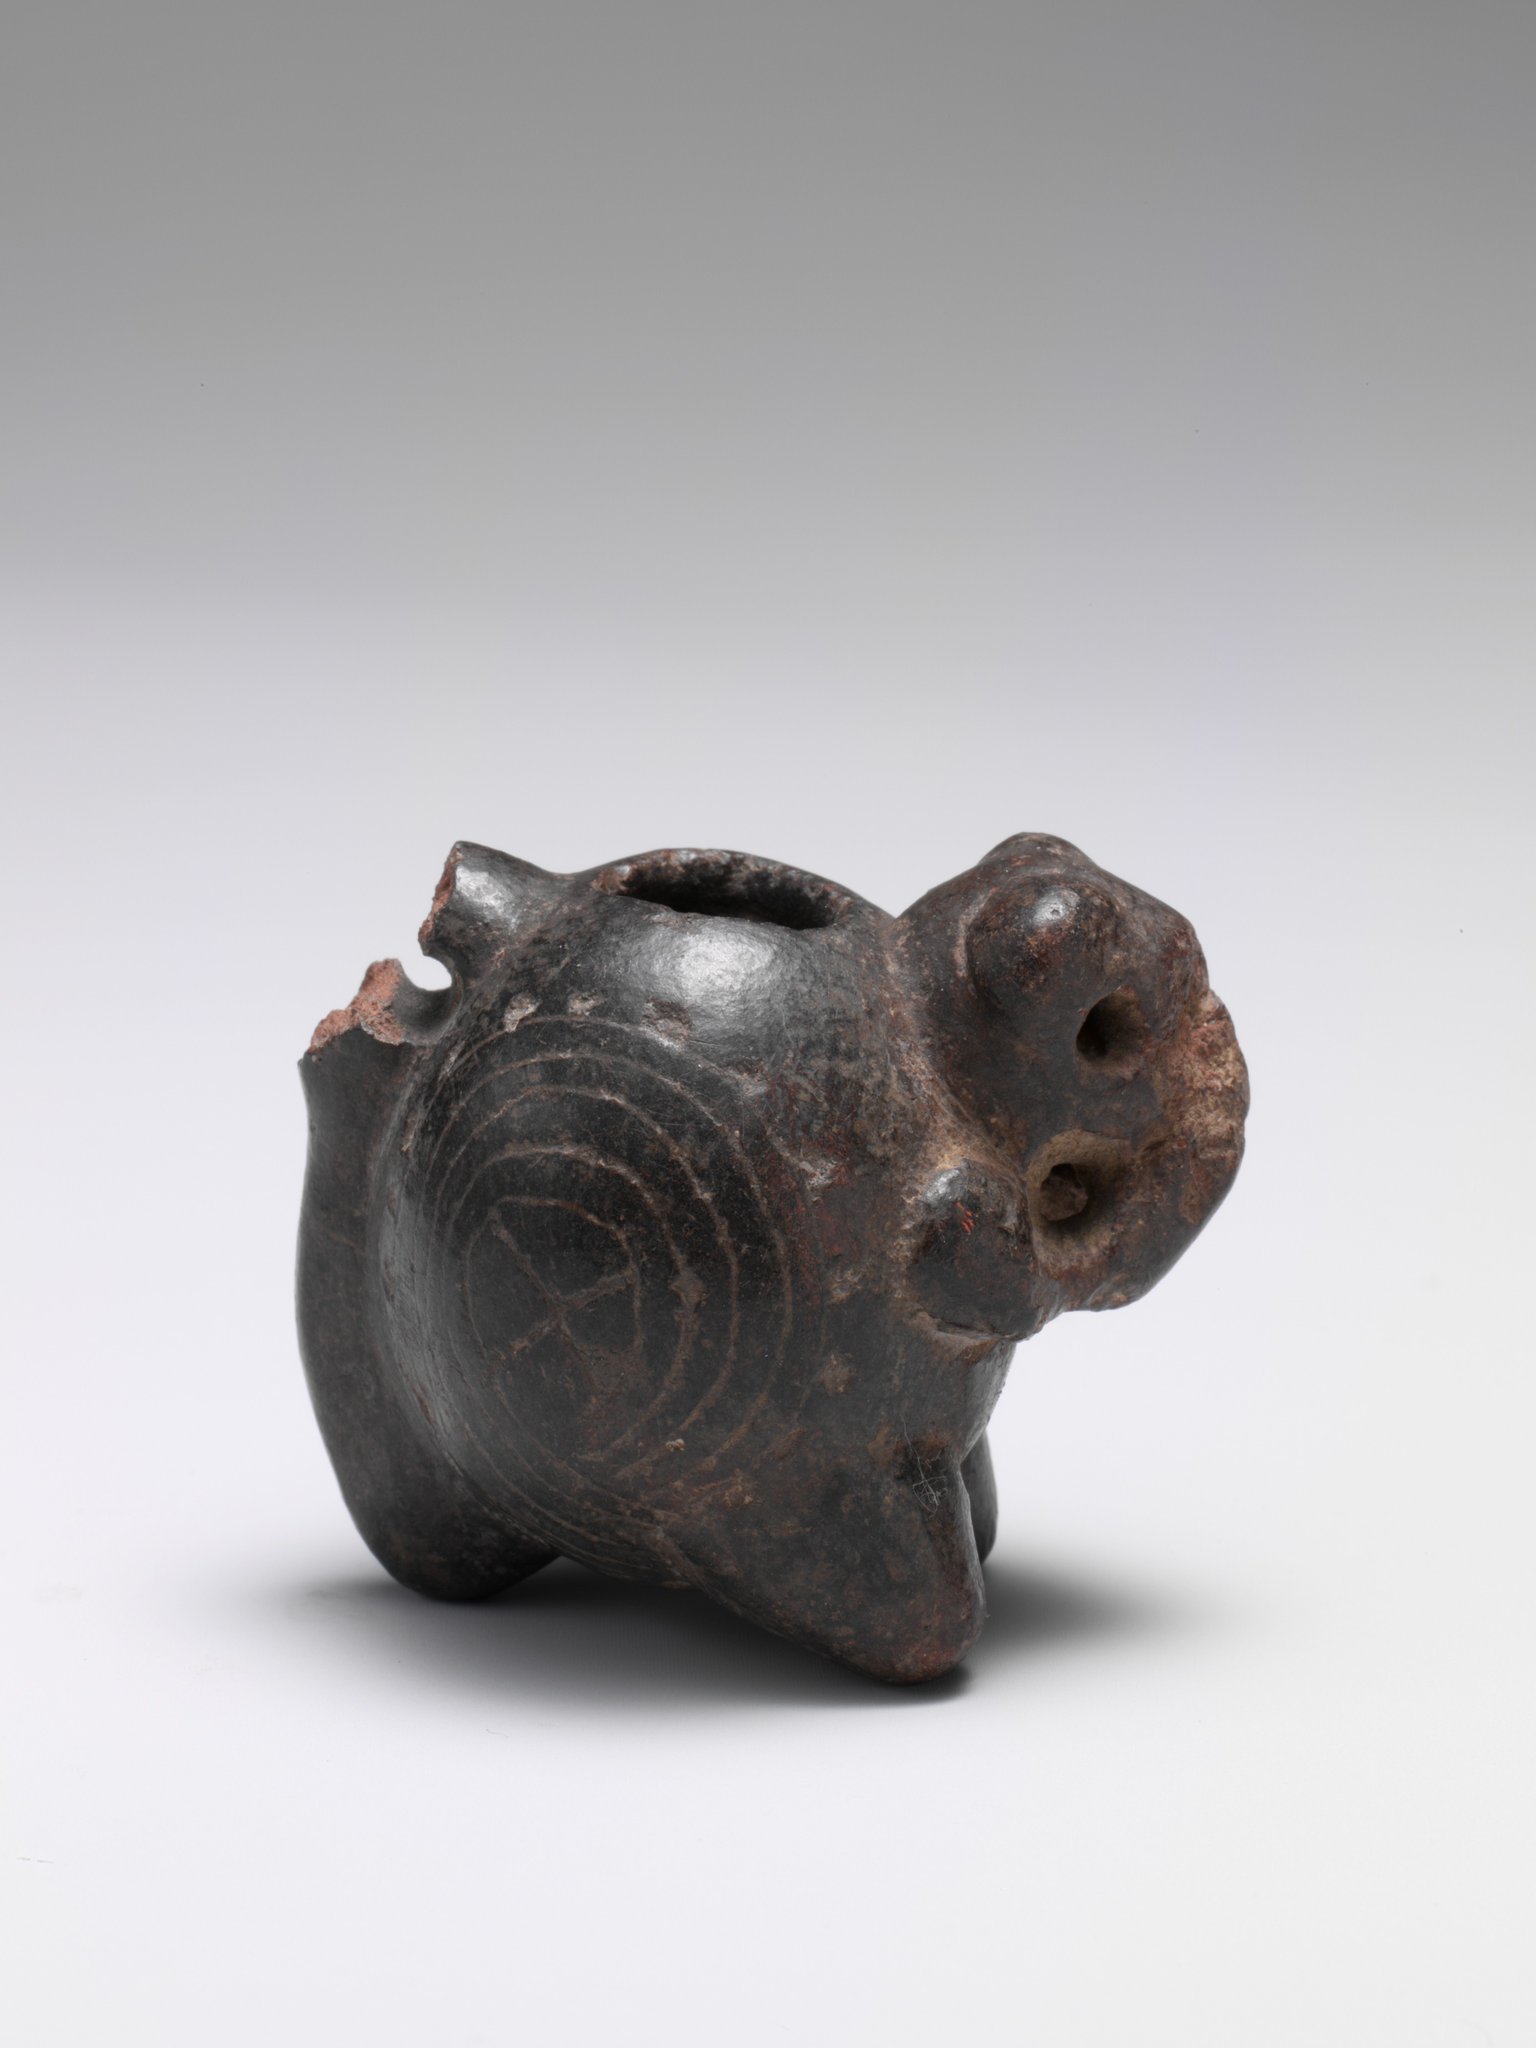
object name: pottery whistle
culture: costa rican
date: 800-1500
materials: clay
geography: costa rica